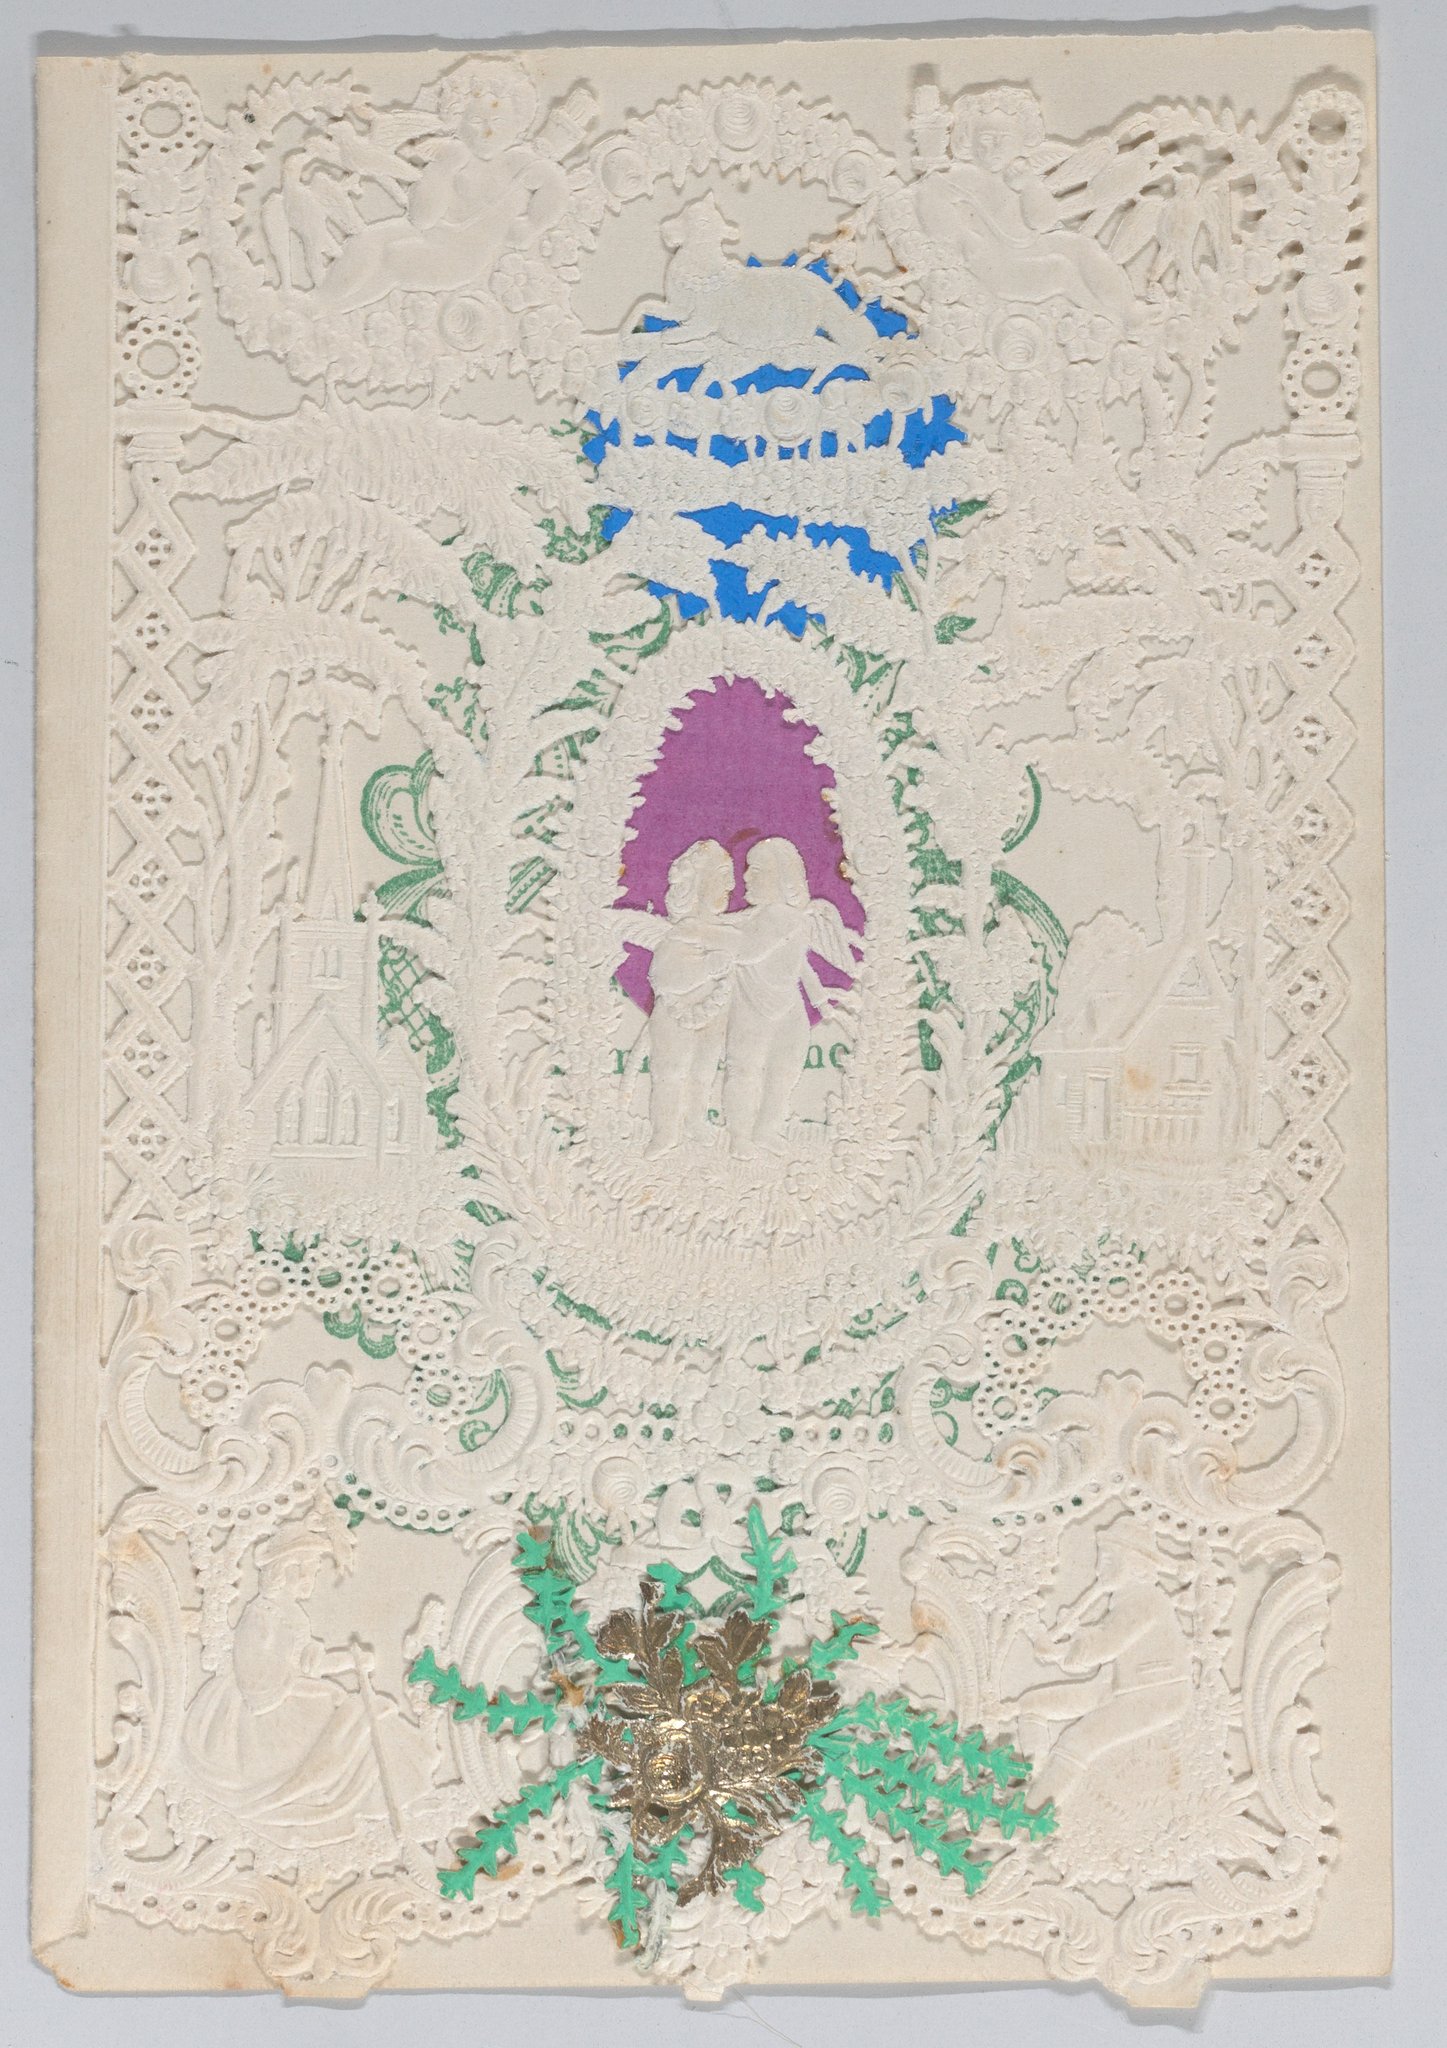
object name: valentine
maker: Anonymous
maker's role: artist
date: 1834-1866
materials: paper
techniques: chromolithography, embossing, gilding